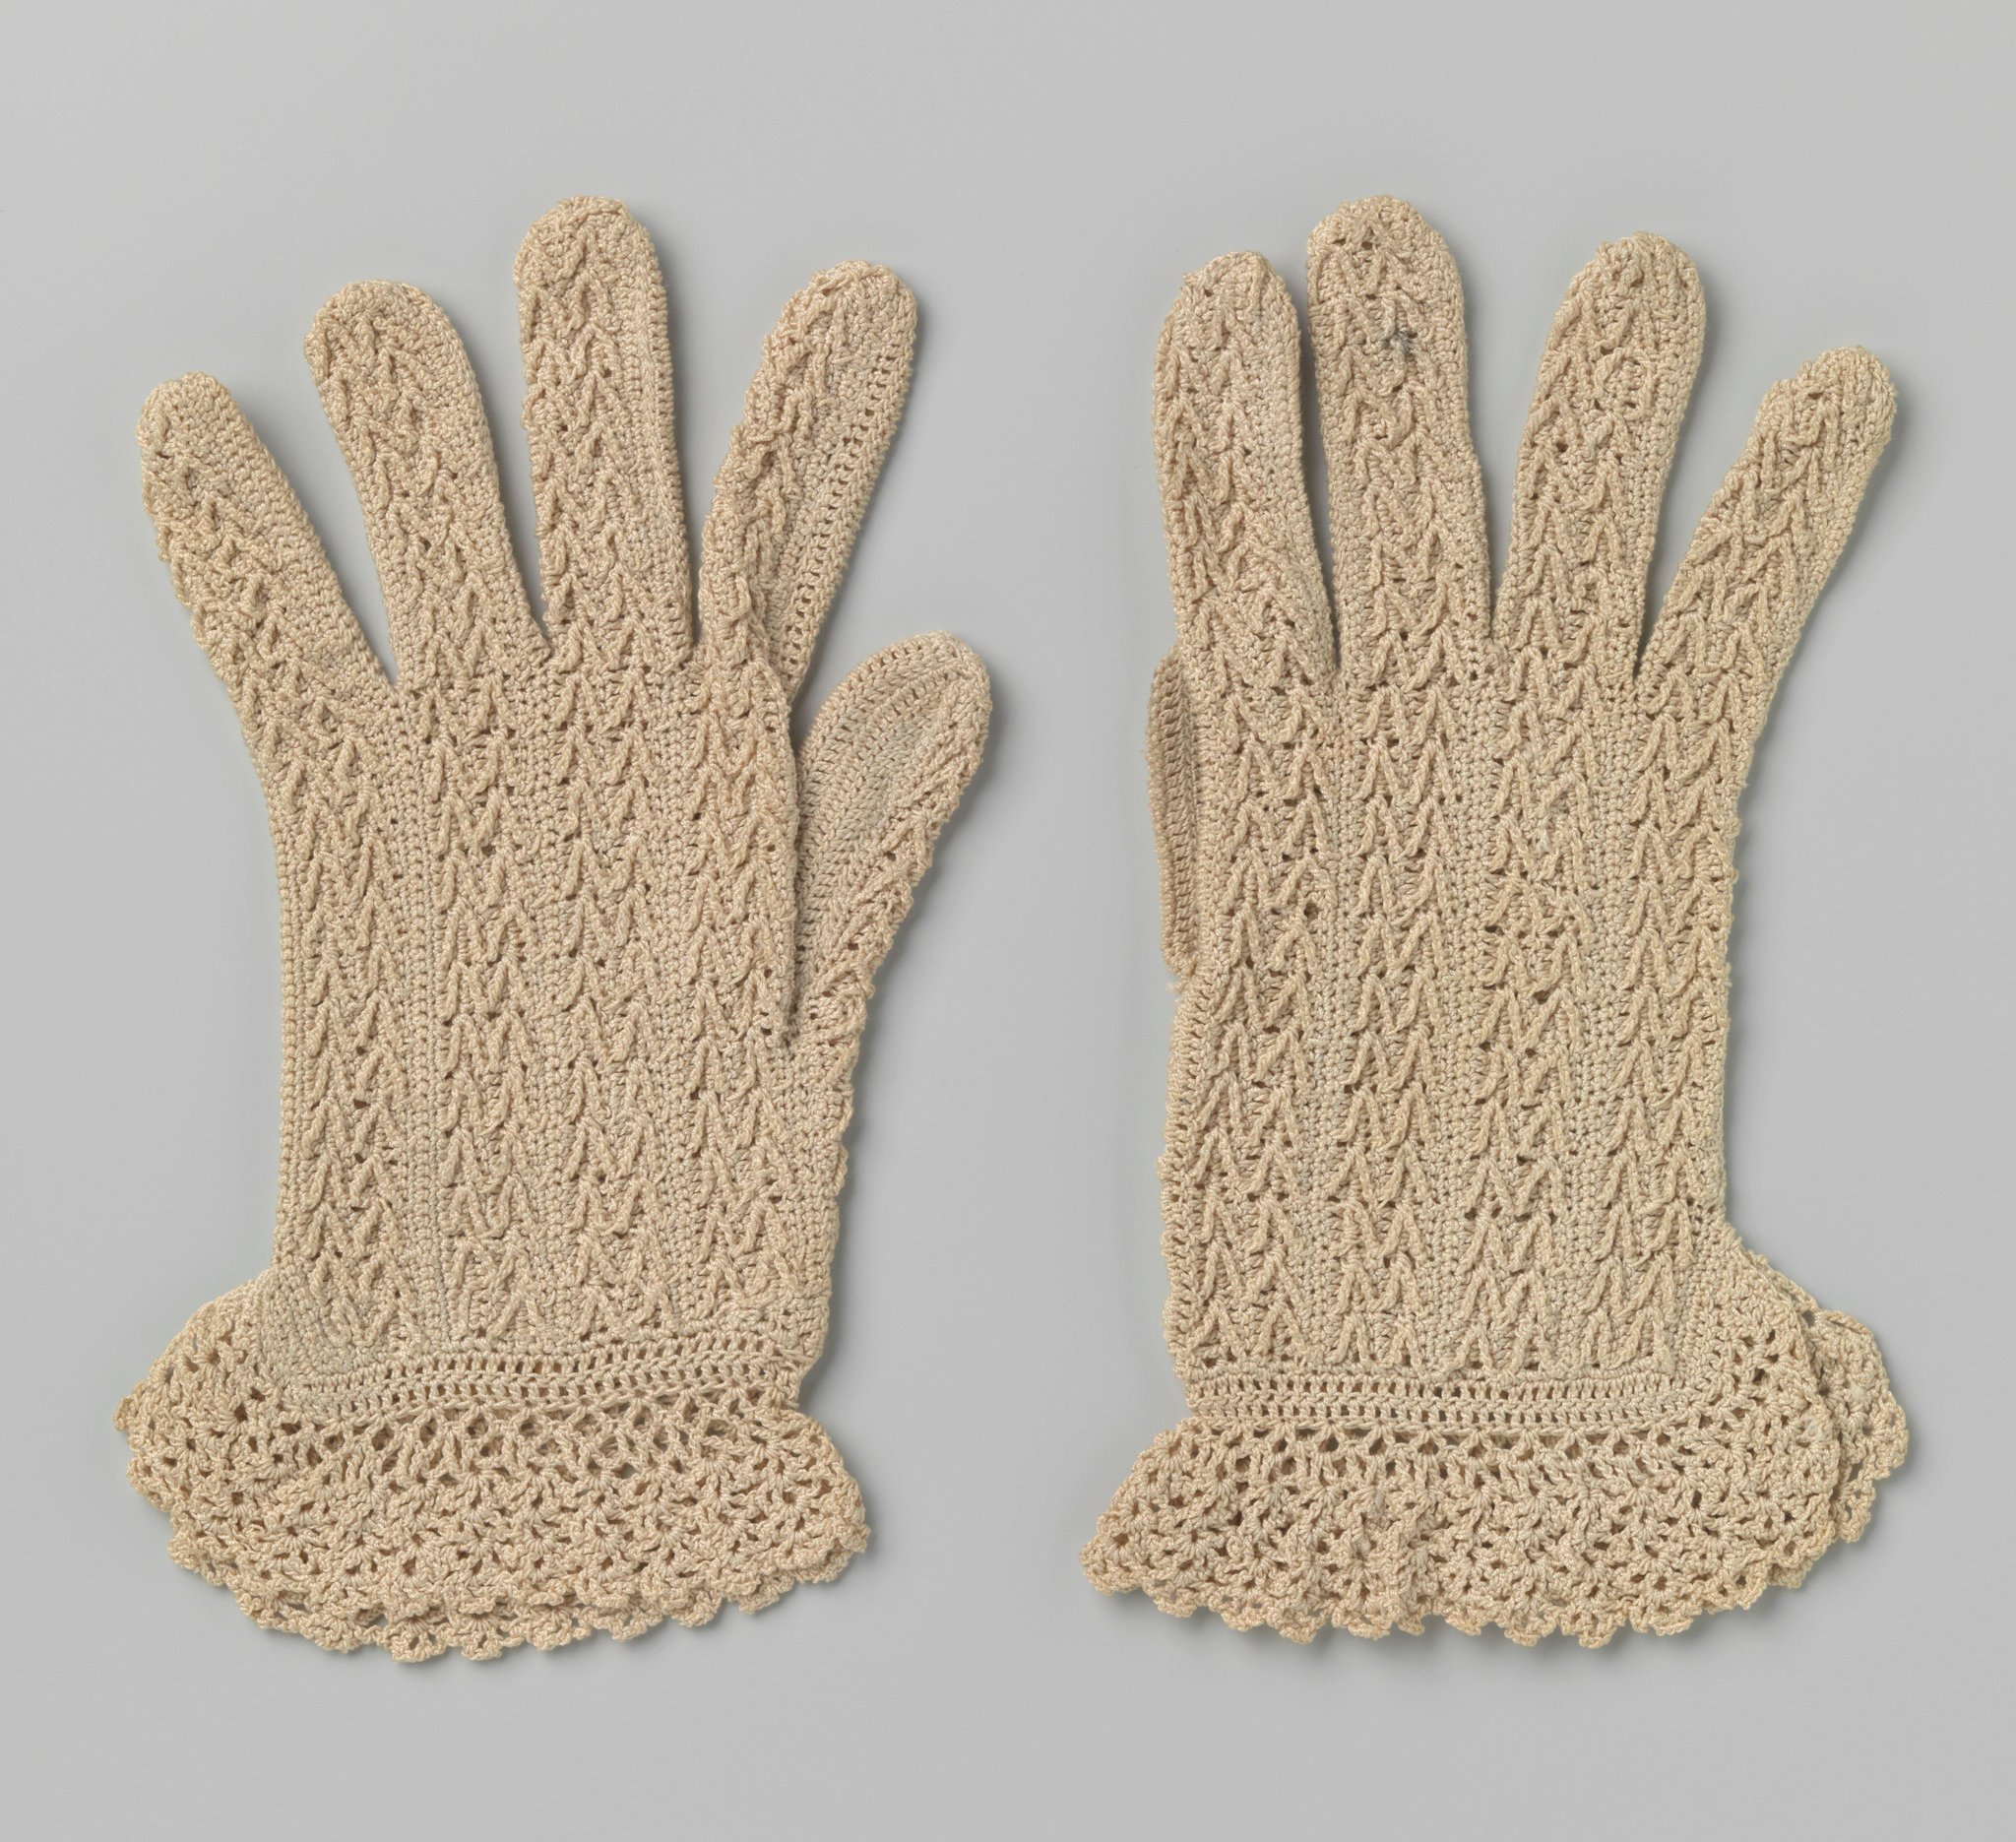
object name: clothing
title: Pair of crocheted gloves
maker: Anonymous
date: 1850-1900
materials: satin cotton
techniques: crochet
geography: netherlands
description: Until the 1950s, it was usual to wear gloves outdoors. These gloves would be made of leather or some other stretchable material. In the summer women often wore crocheted gloves like these, as well.